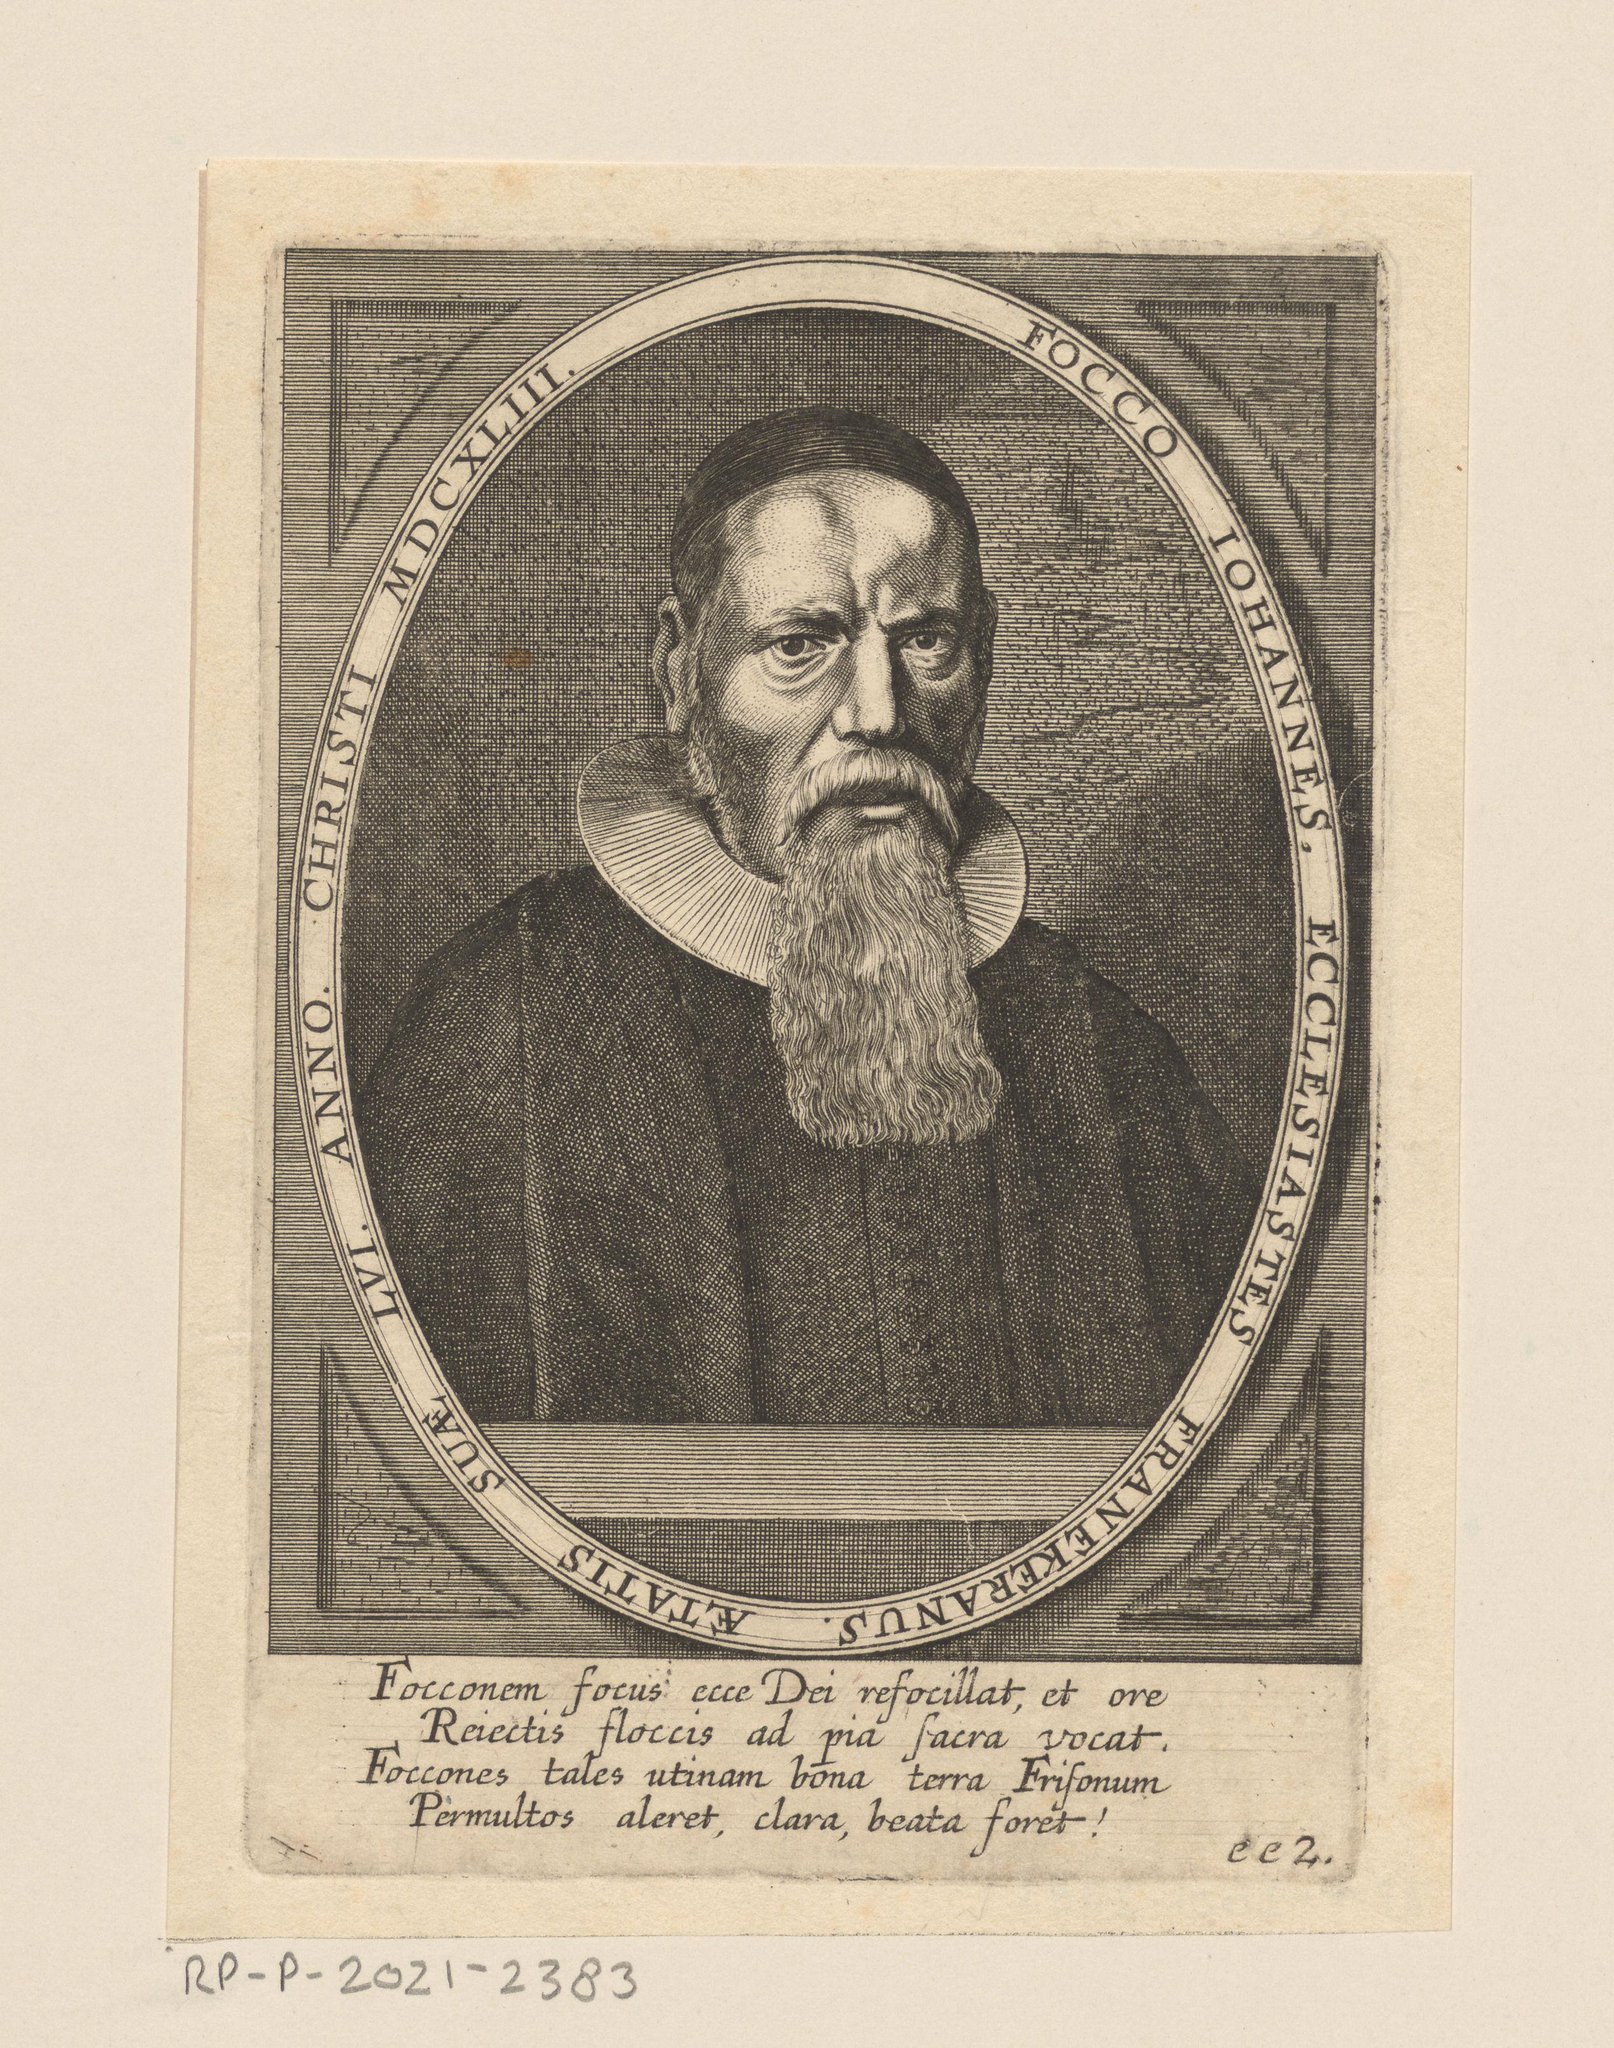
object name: print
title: Portret van Johannes Focco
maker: clemens ammon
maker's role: print maker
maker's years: 1627-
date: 1650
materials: paper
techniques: engraving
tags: organizational aspects ~ protestant churches, historical persons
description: Prent mogelijk uit: Boissard, Jean Jacques. Bibliotheca chalcographica (...) VII pars. Frankfurt am Main: Johannes Ammon, 1650.